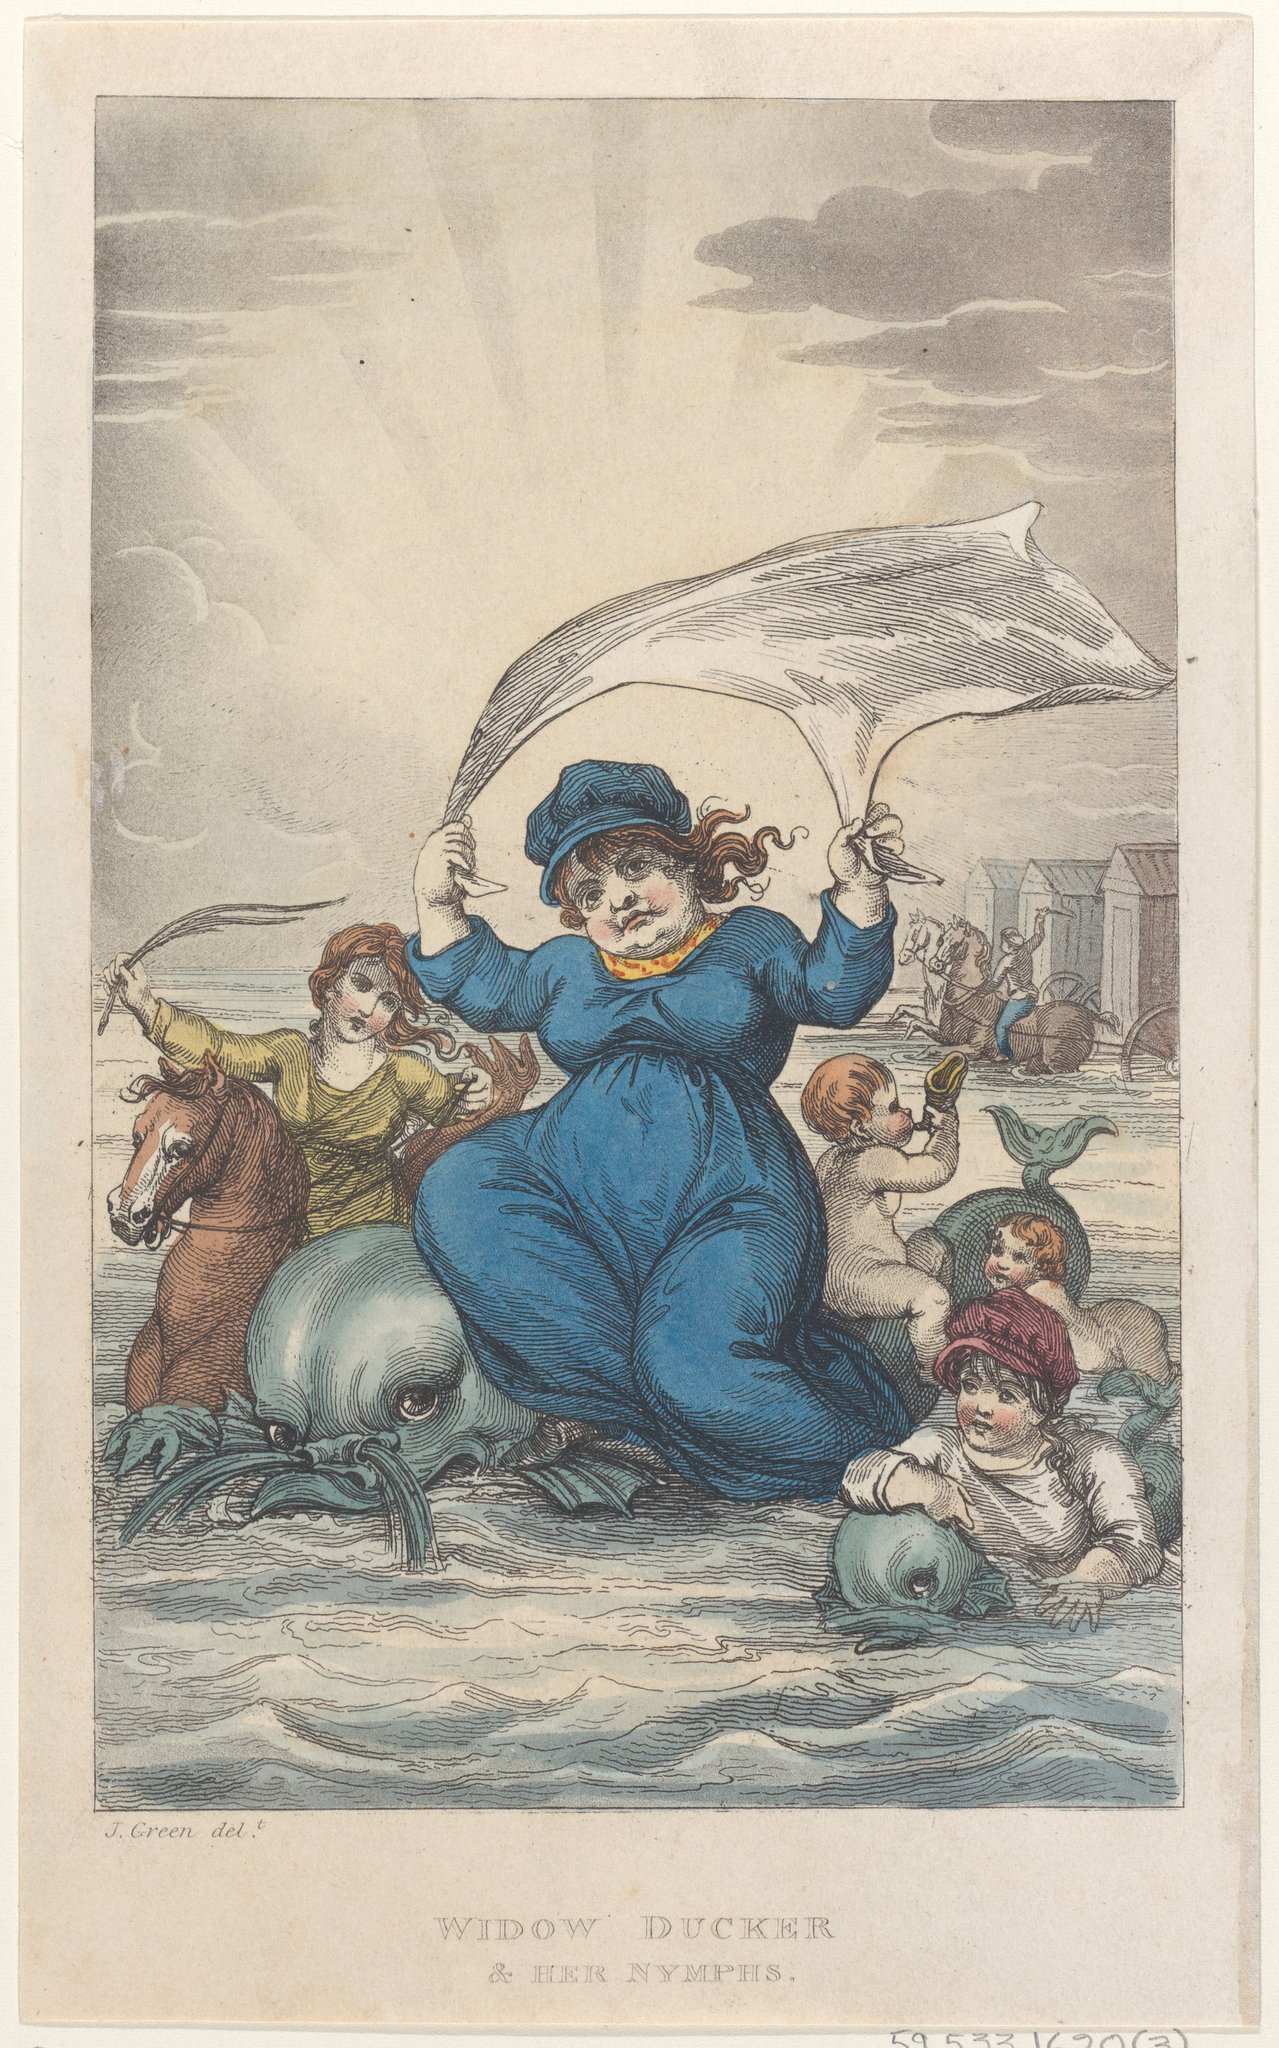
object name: print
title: Widow Ducker & Her Nymphs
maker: thomas rowlandson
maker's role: artist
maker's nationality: british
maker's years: 1757-1827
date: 1813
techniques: aquatint, etching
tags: women,fish,horses